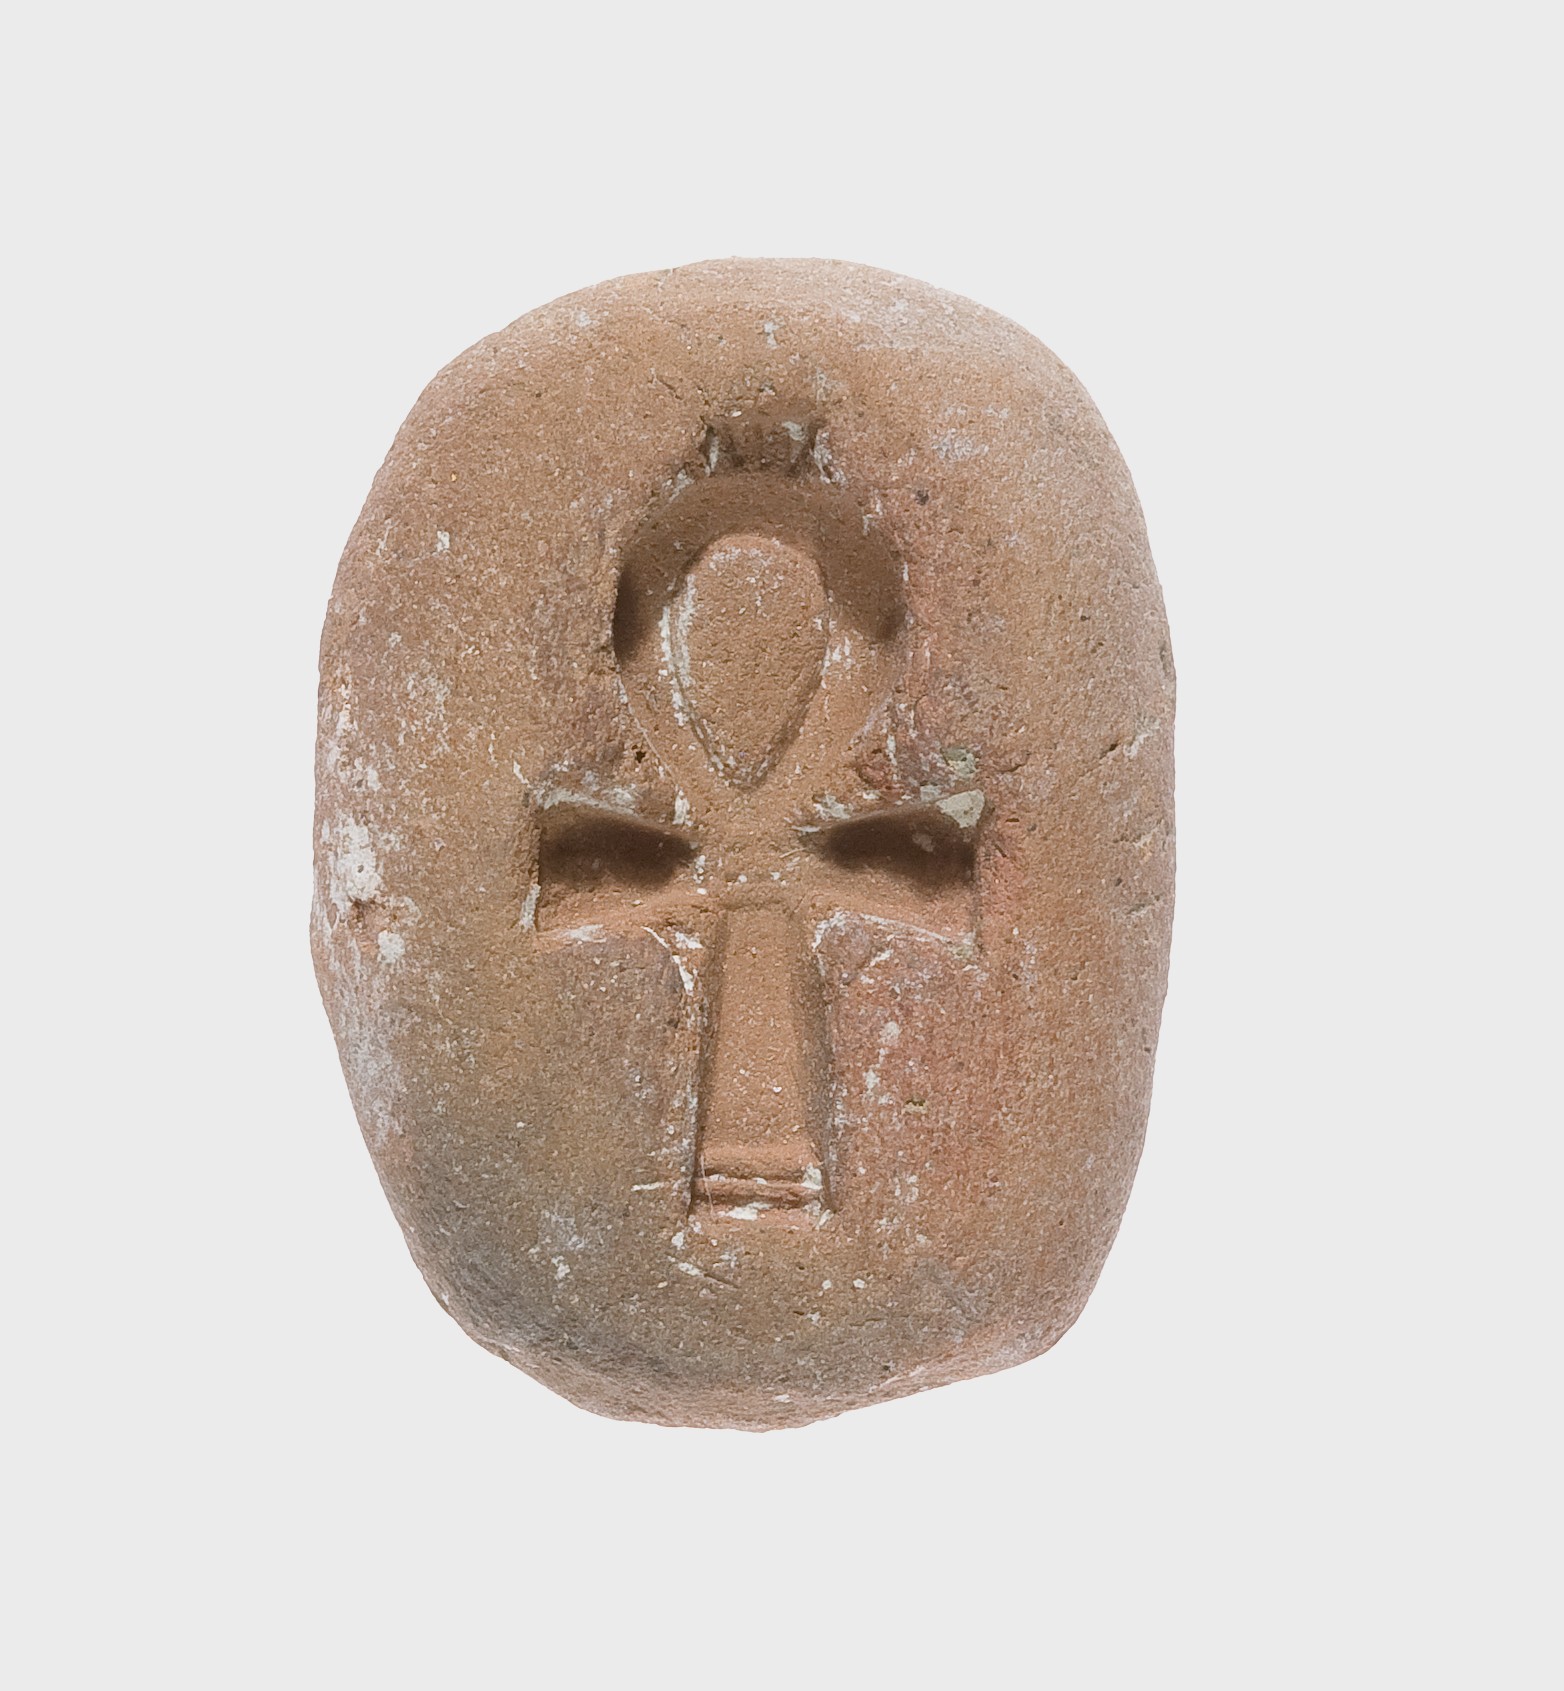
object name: mold, amulet, ankh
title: Mold for an Ankh Amulet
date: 1390-1352 BCE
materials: pottery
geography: egypt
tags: ankh